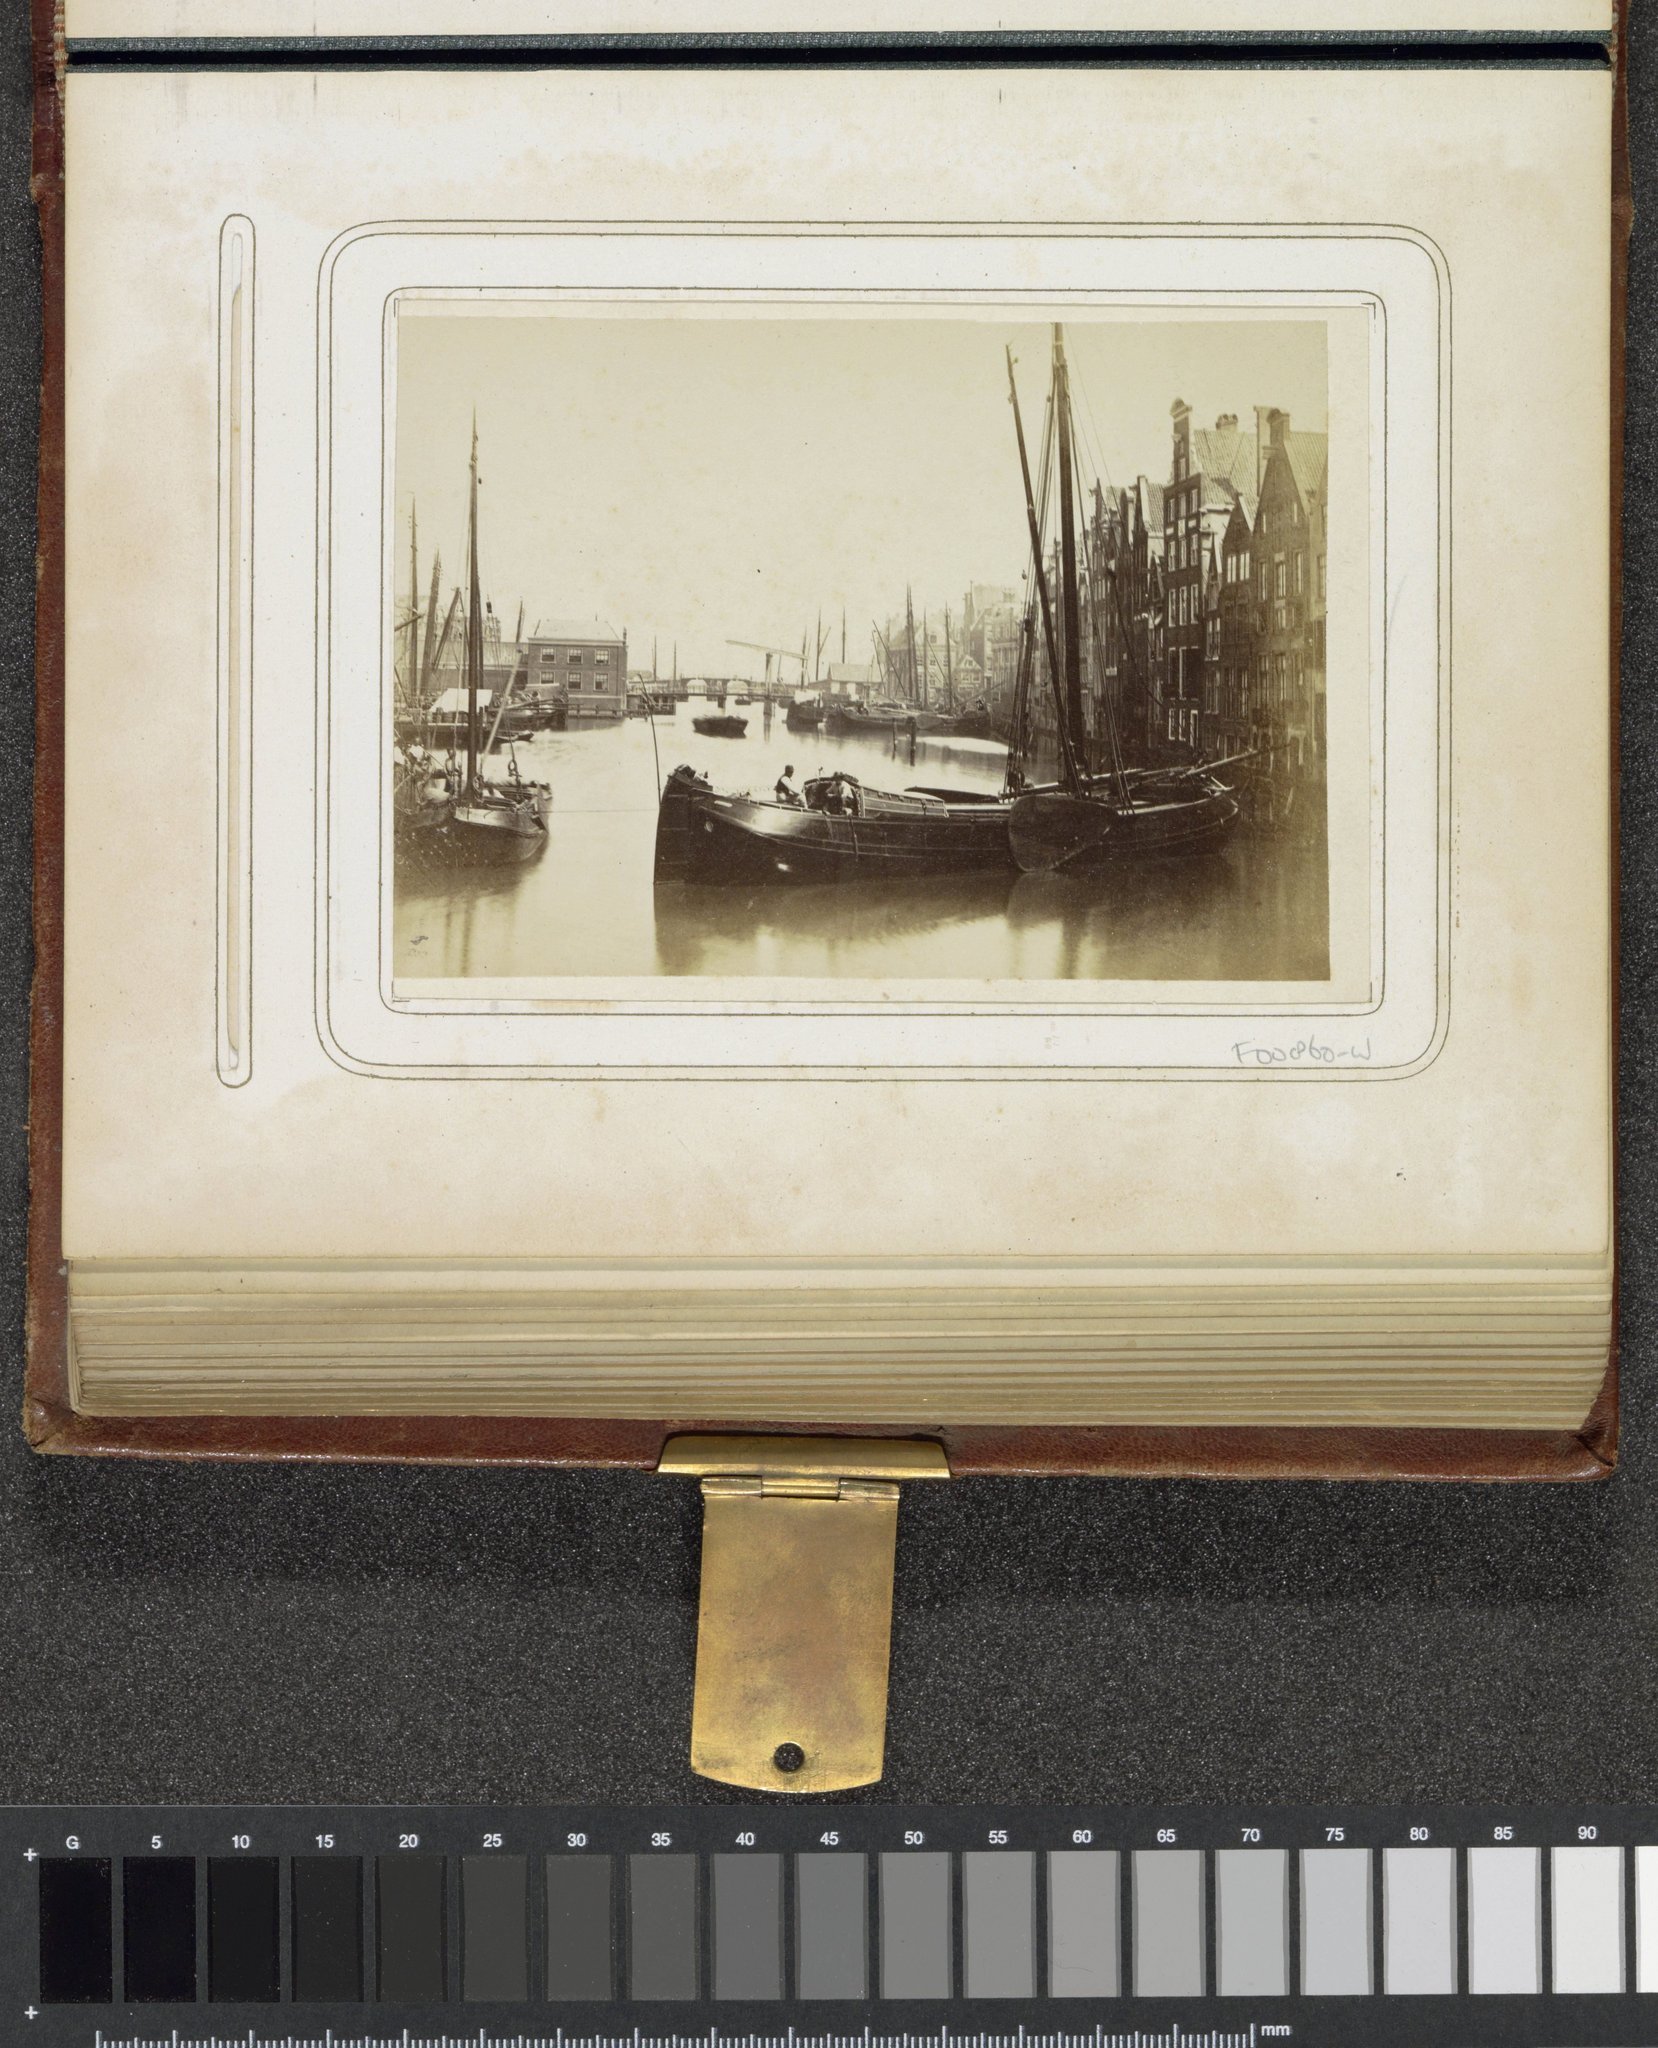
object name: photograph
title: Het Damrak met beurtschip. Amsterdam. Vue du canal dit Damrak.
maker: andries jager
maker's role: publisher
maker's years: 1825-1905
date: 1860-1875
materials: cardboard, paper, photographic support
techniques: albumen print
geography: amsterdam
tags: freight vessel, canal, prospect of city, town panorama, silhouette of city, amsterdam